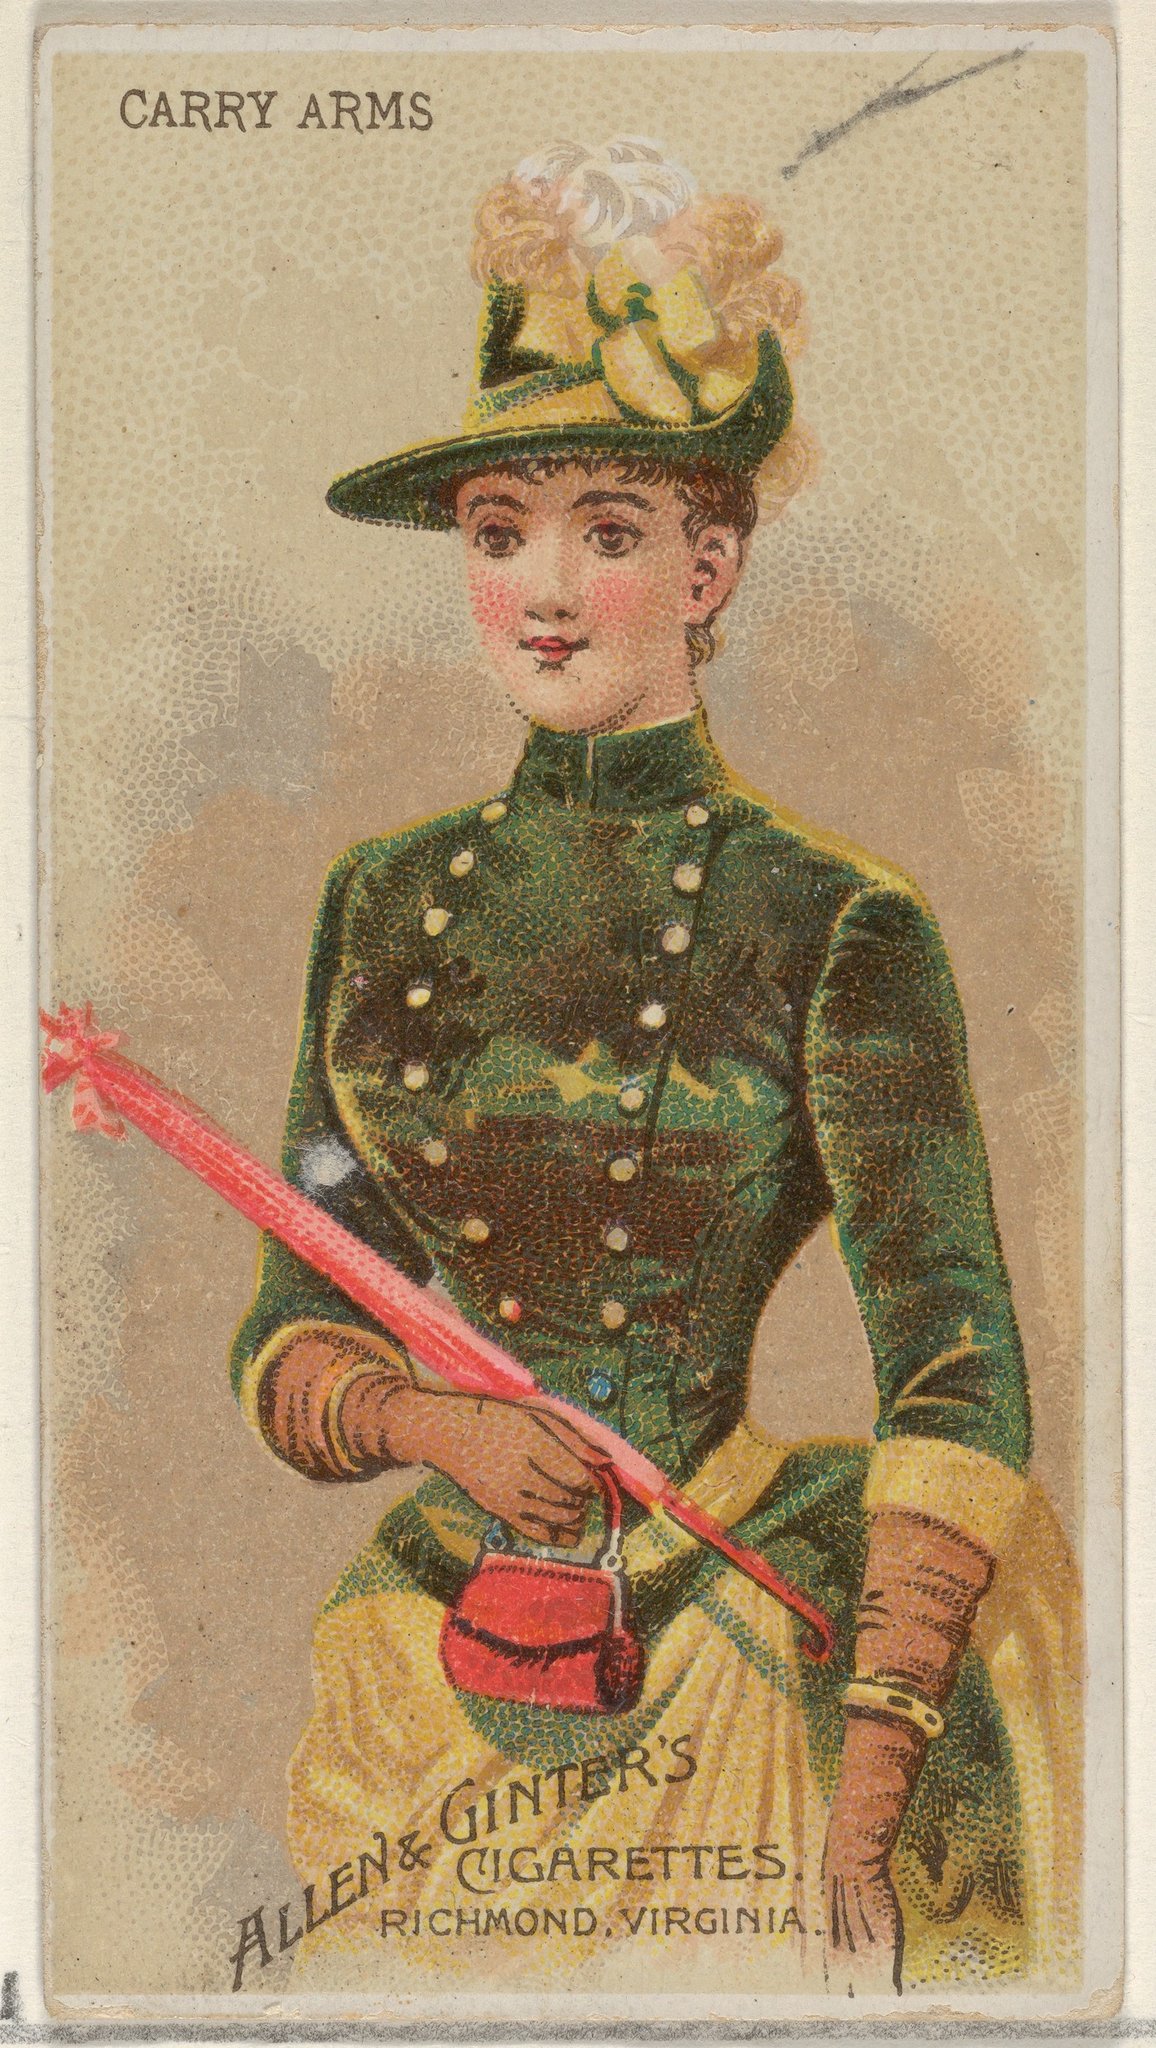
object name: print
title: Carry Arms, from the Parasol Drills series (N18) for Allen & Ginter Cigarettes Brands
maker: allen & ginter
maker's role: publisher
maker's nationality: american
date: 1888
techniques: color lithograph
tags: women